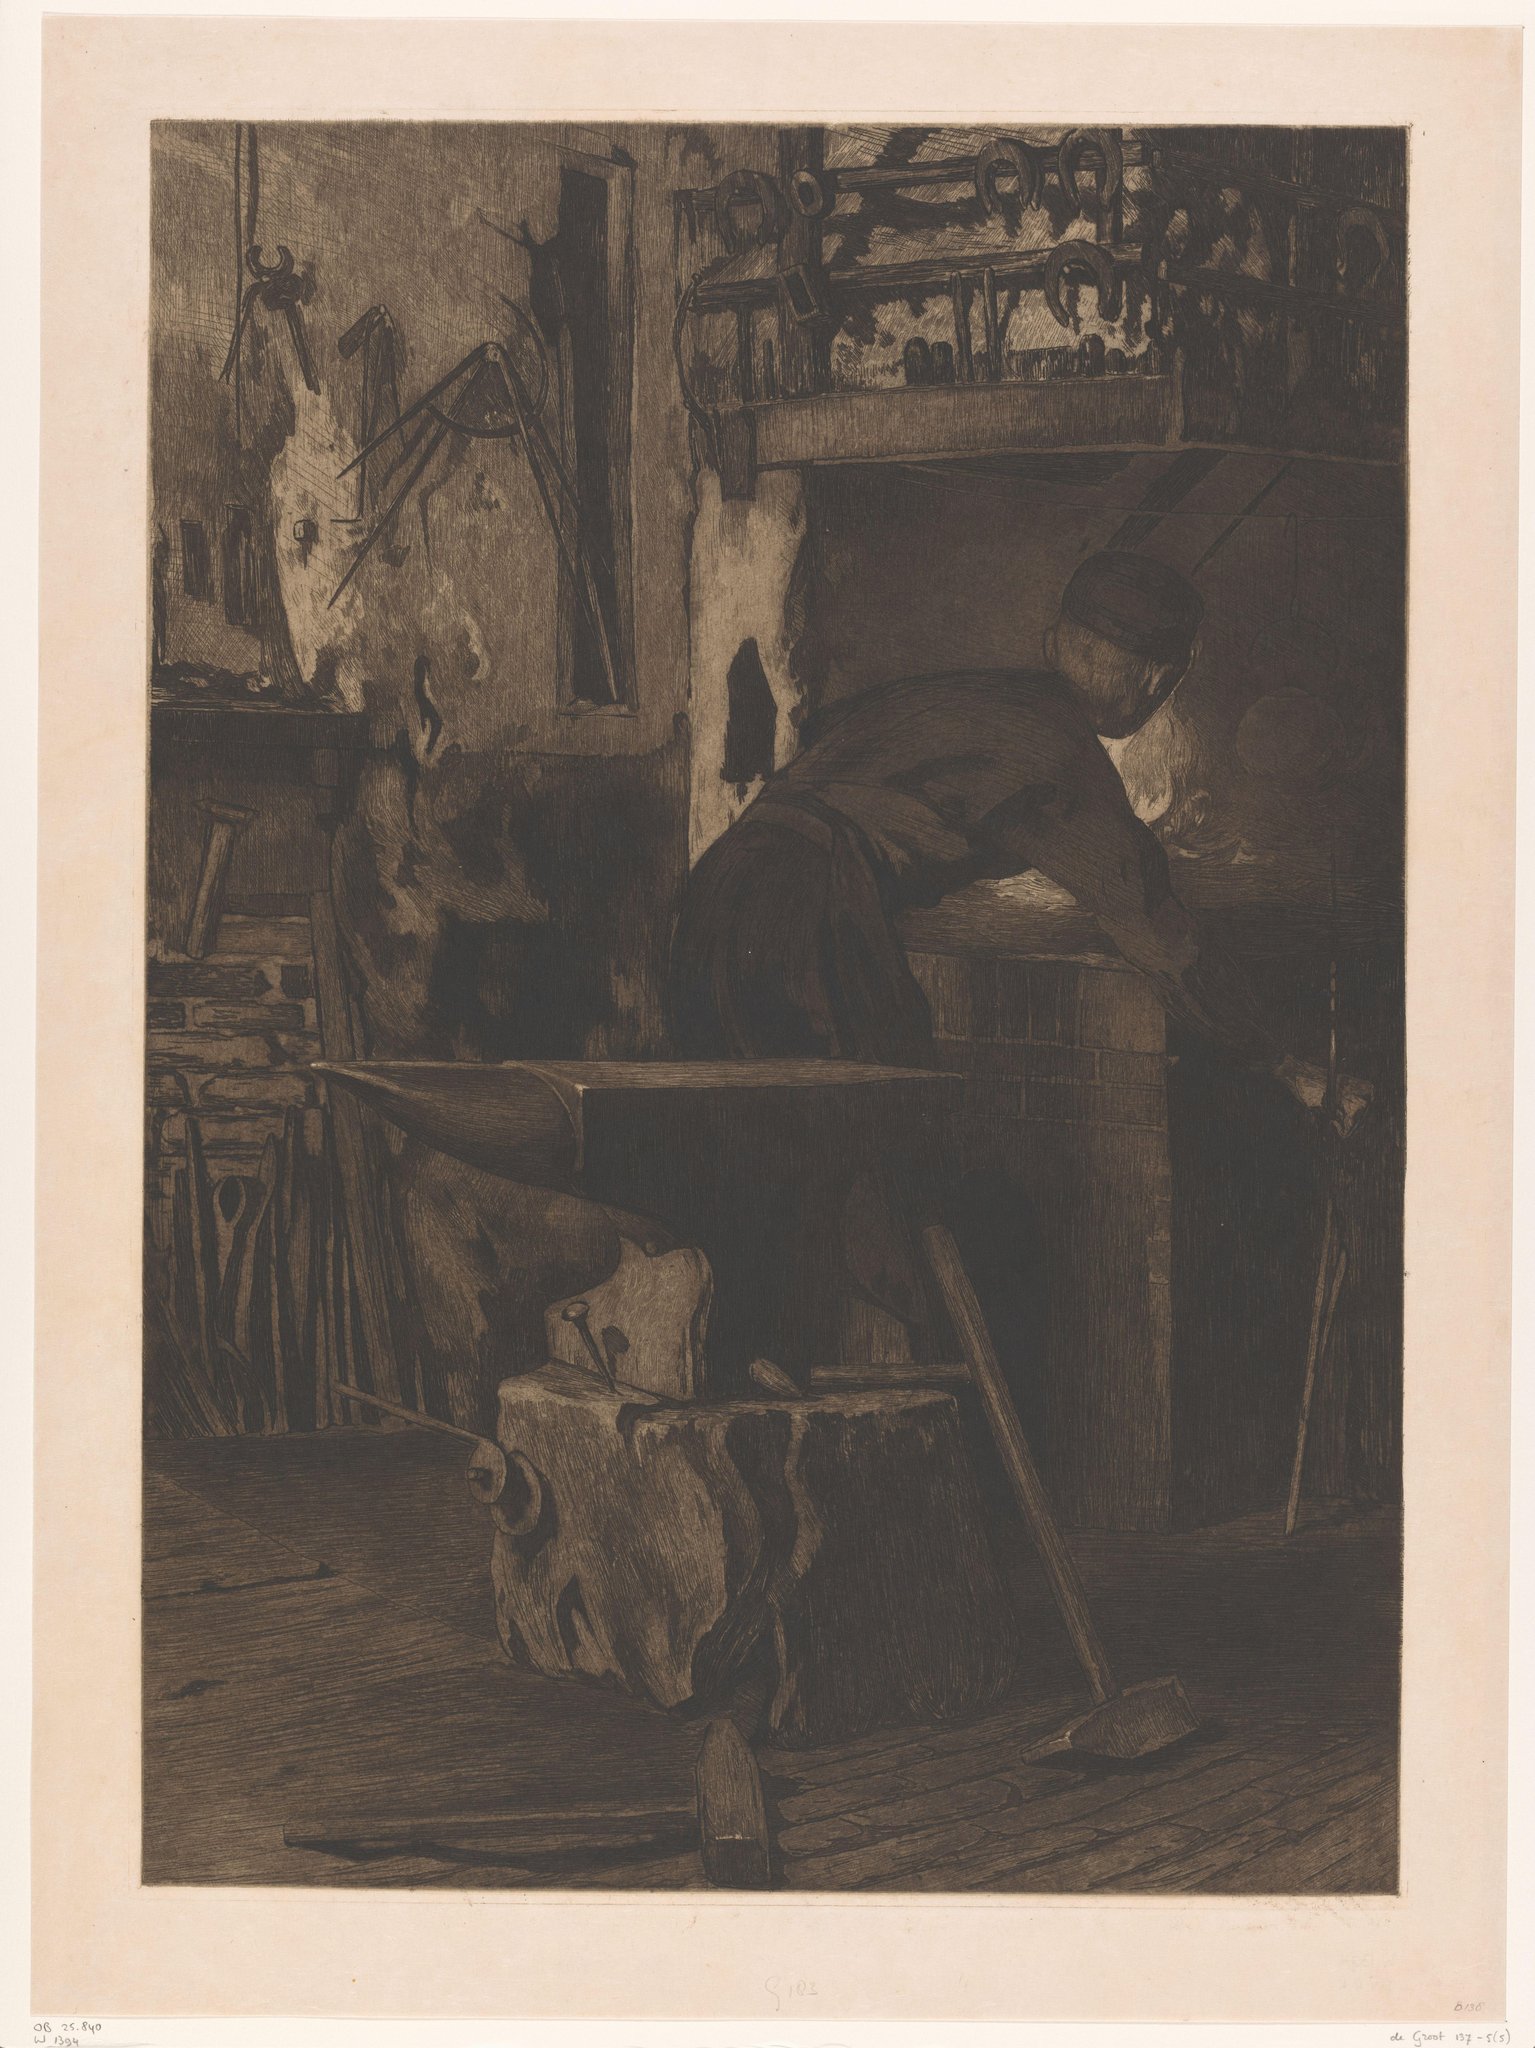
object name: print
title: Smidse met vuur (Jan)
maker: willem witsen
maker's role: draughtsman, painter, print maker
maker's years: 1860-1923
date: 1908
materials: paper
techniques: aquatint, etching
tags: smith, blacksmith (+ men (labourers)), tools, aids, implements ~ crafts and industries: anvil, wijk bij duurstede